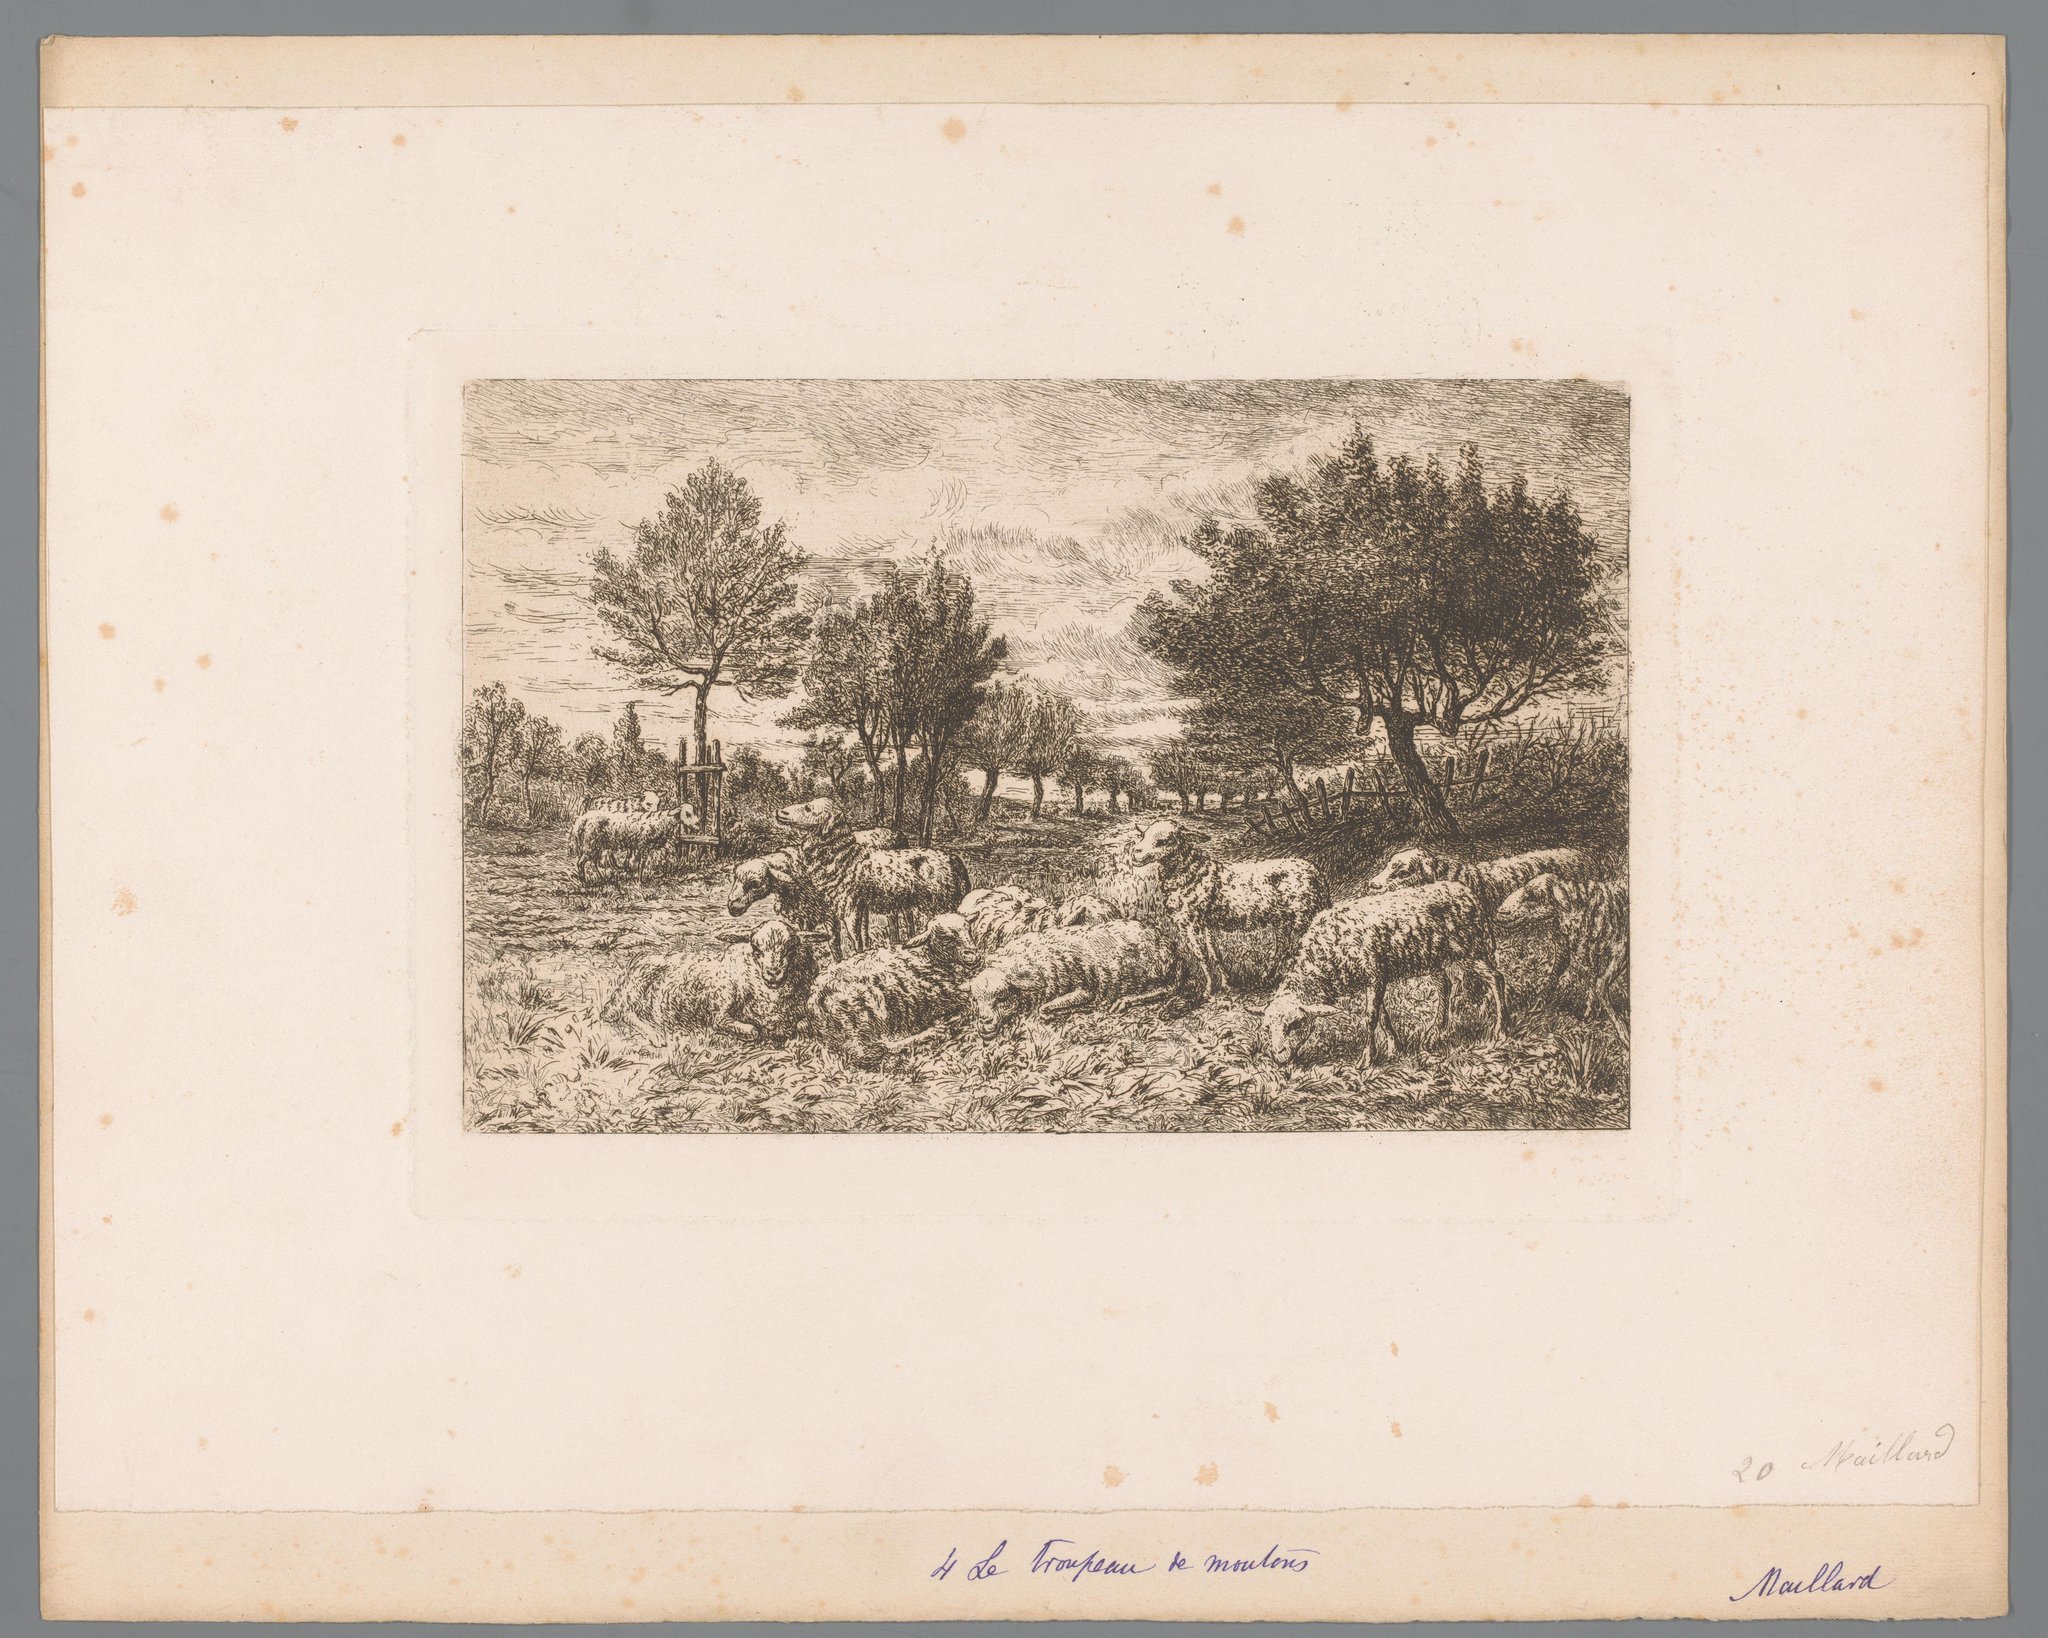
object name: print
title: Landschap met kudde schapen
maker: maillard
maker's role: print maker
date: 1850-1899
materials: paper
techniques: etching, intaglio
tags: landscapes, sheep, herd, flock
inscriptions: collector's mark: Lugt 2228